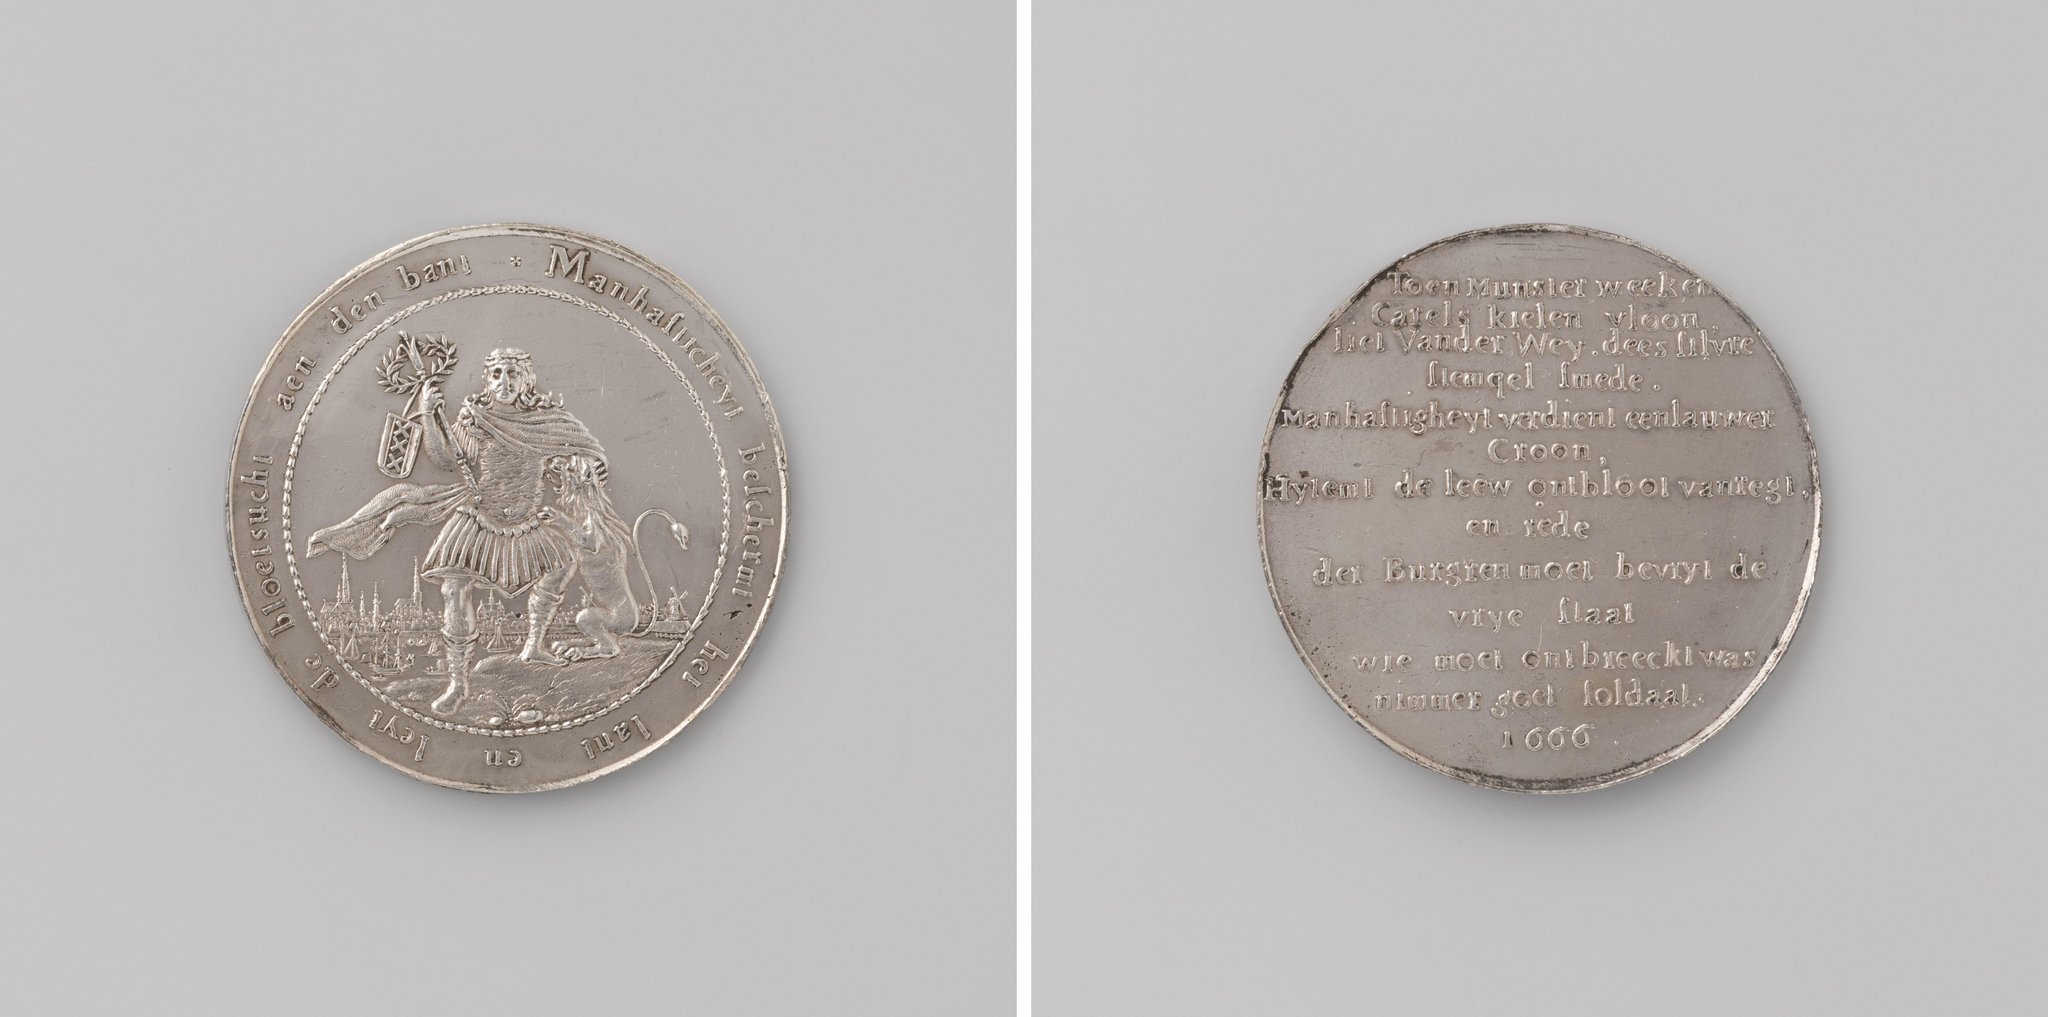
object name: history medal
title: Vierdaagse zeeslag, penning uit de verzuimde wachtboetes van de Amsterdamse schutterij vervaardigd en aan de wachthebbende schutters uitgedeeld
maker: Anonymous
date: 1666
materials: silver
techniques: engraving, striking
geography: amsterdam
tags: amsterdam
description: Zilveren penning. Voorzijde: de Manhaftigheid, afgebeeld als een Romeins soldaat met krans en wapenschild beschermt de Nederlandse leeuw binnen omschrift. Keerzijde: opschrift; randschrift